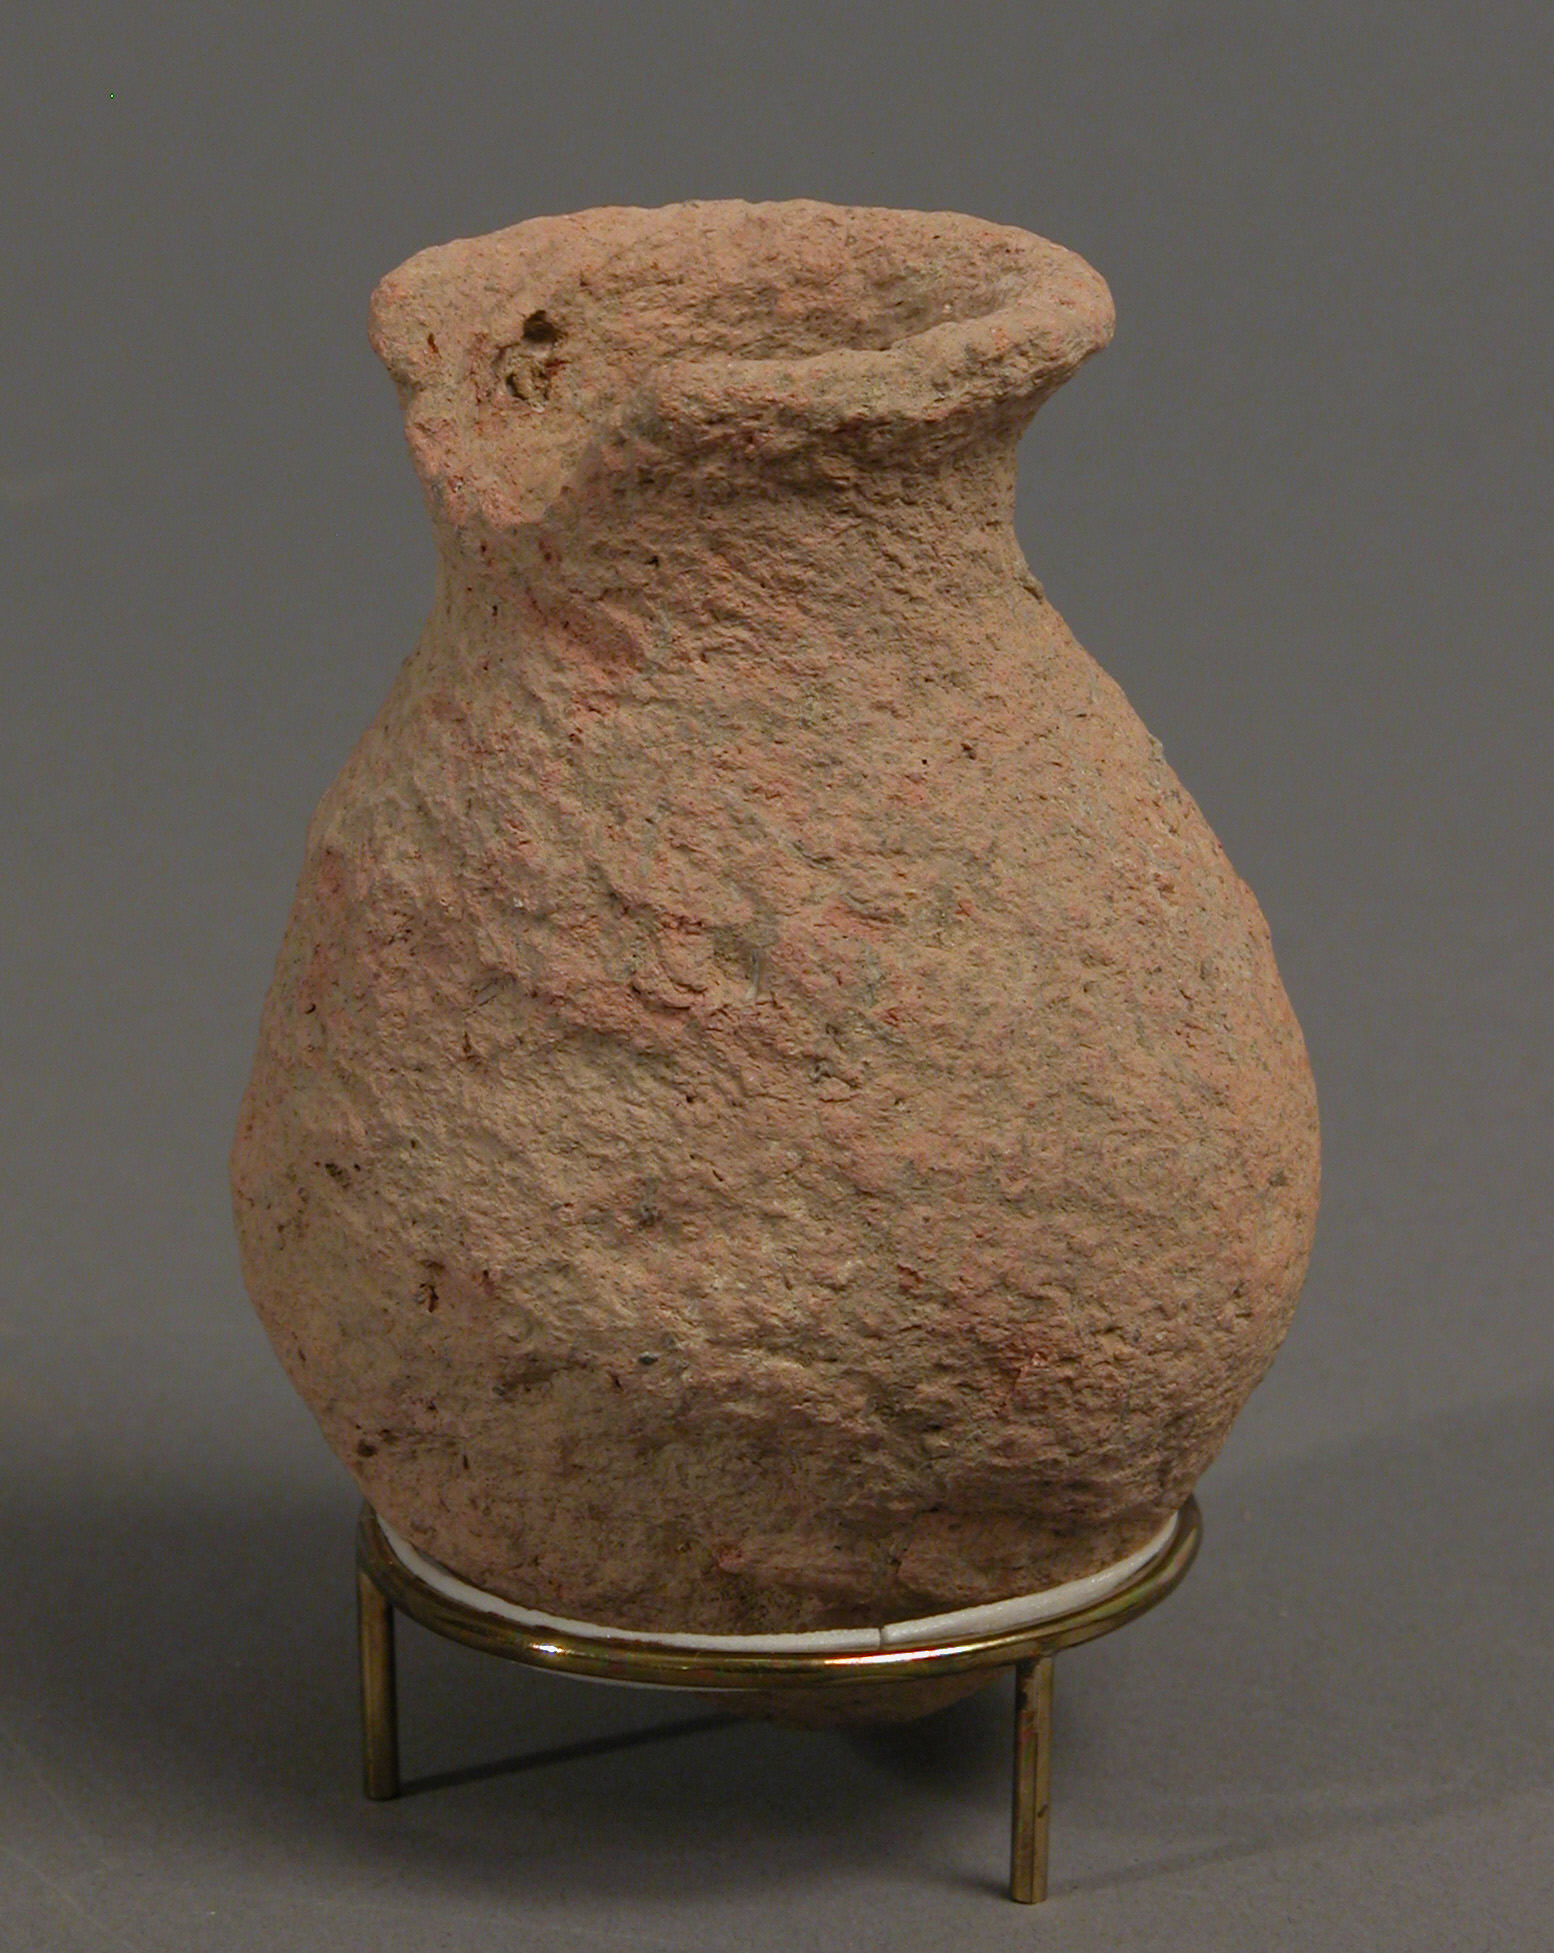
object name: pot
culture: coptic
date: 301-700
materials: earthenware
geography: egypt